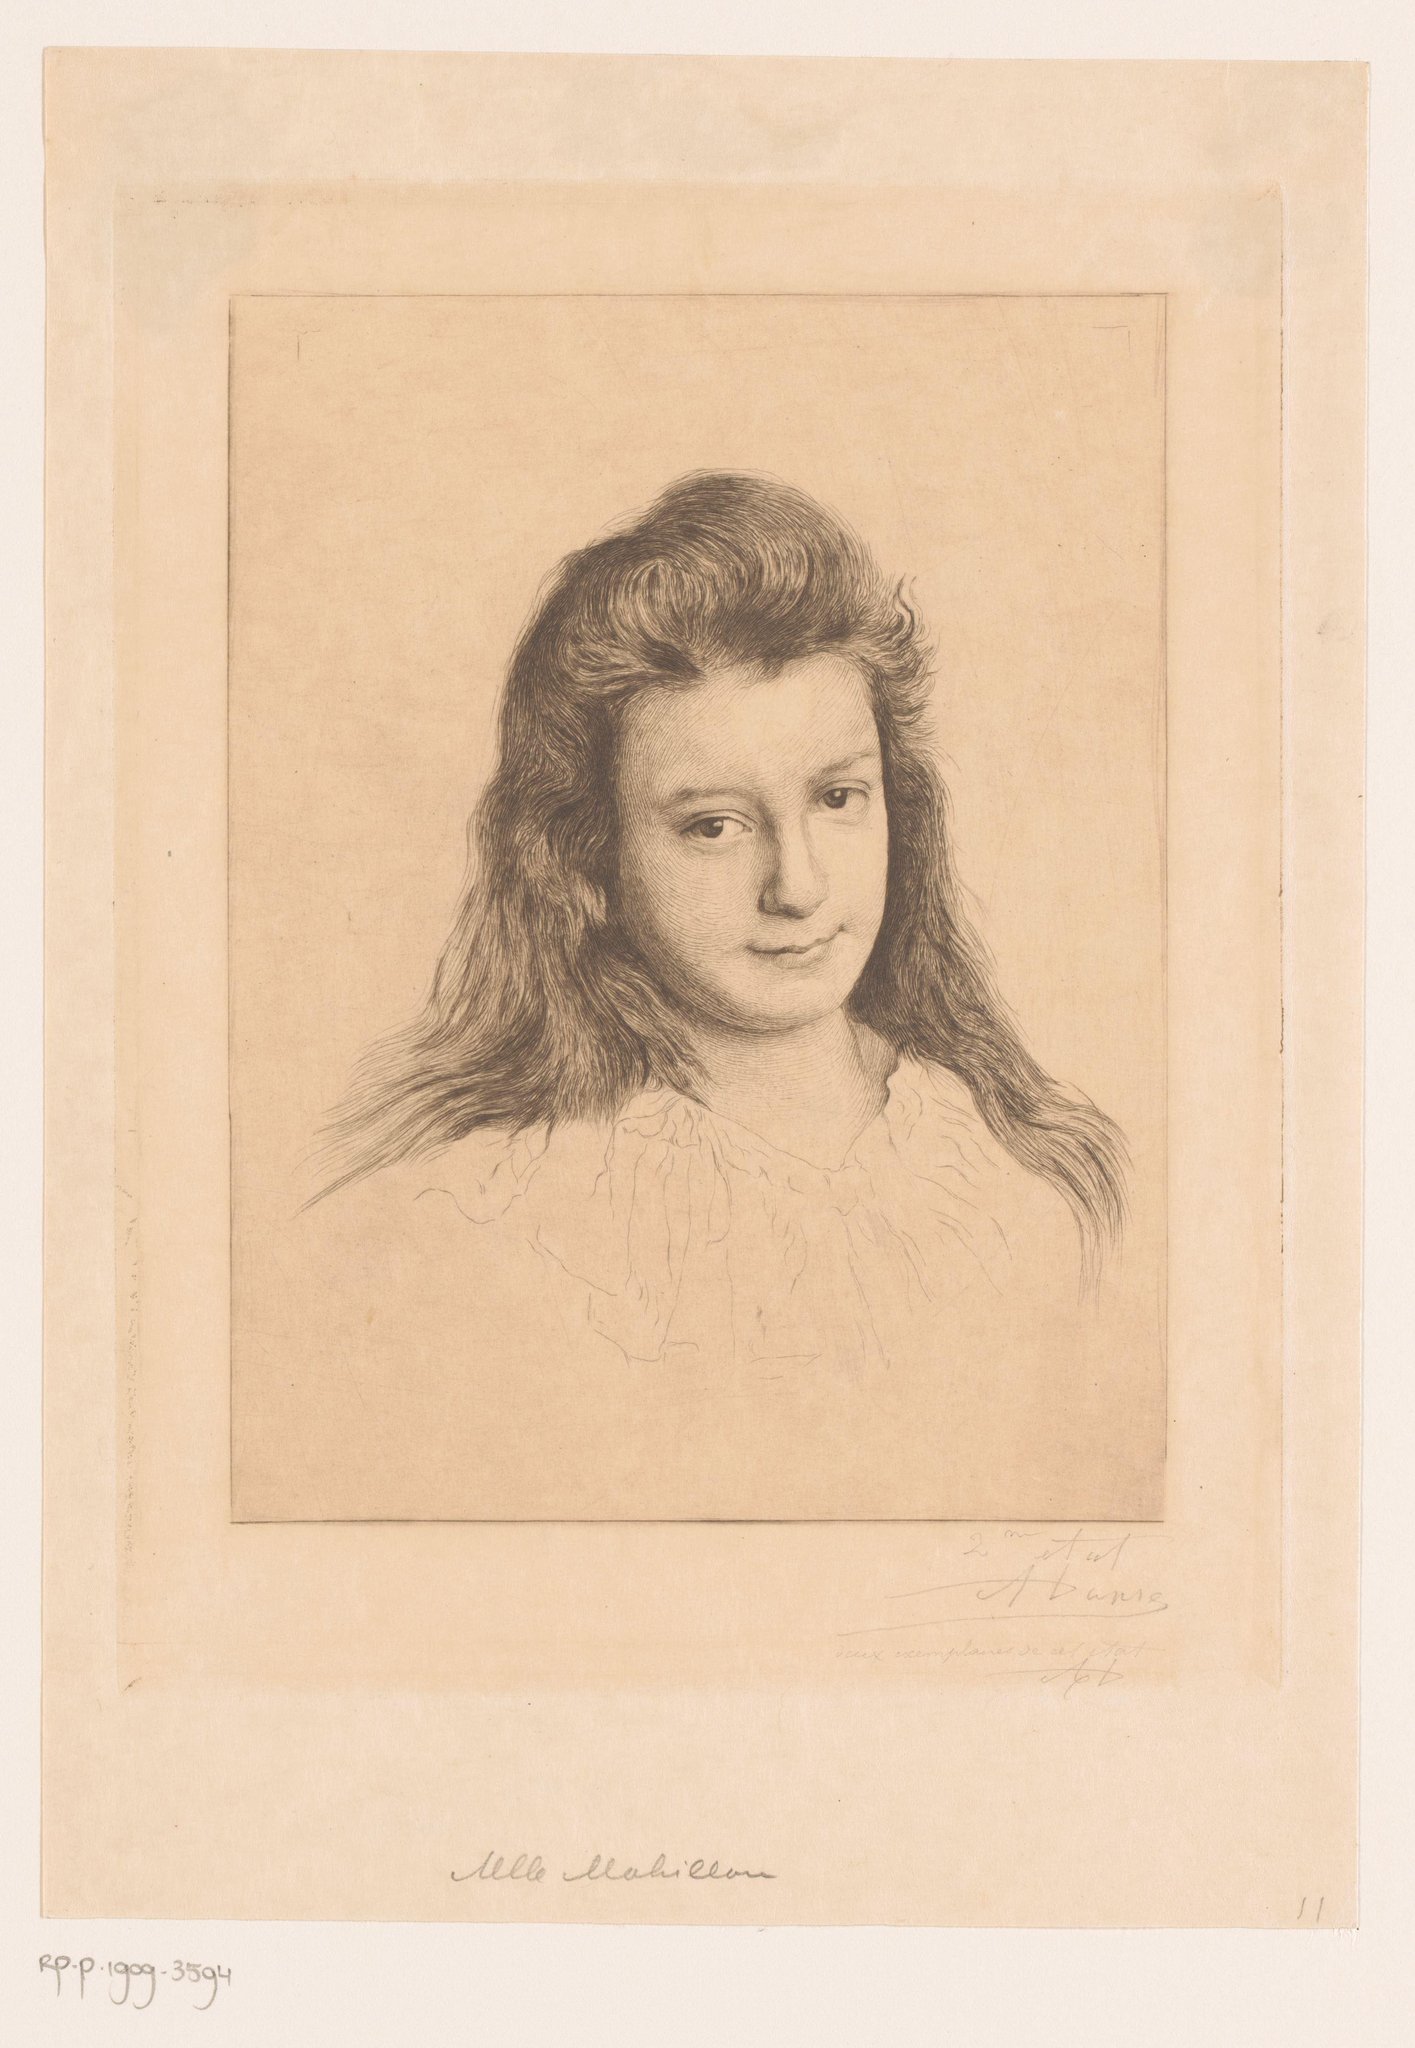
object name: print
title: Portret van de dochter van Victor-Charles Mahillon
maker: auguste danse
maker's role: print maker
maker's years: 1829-1929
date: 1897-1909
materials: paper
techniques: drypoint, etching, intaglio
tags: historical person (with name) - bb - woman - historical person (with name) portrayed alone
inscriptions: annotation: ‘2ème état; deux exemplaires de cet etat’, collector's mark: Lugt 2228